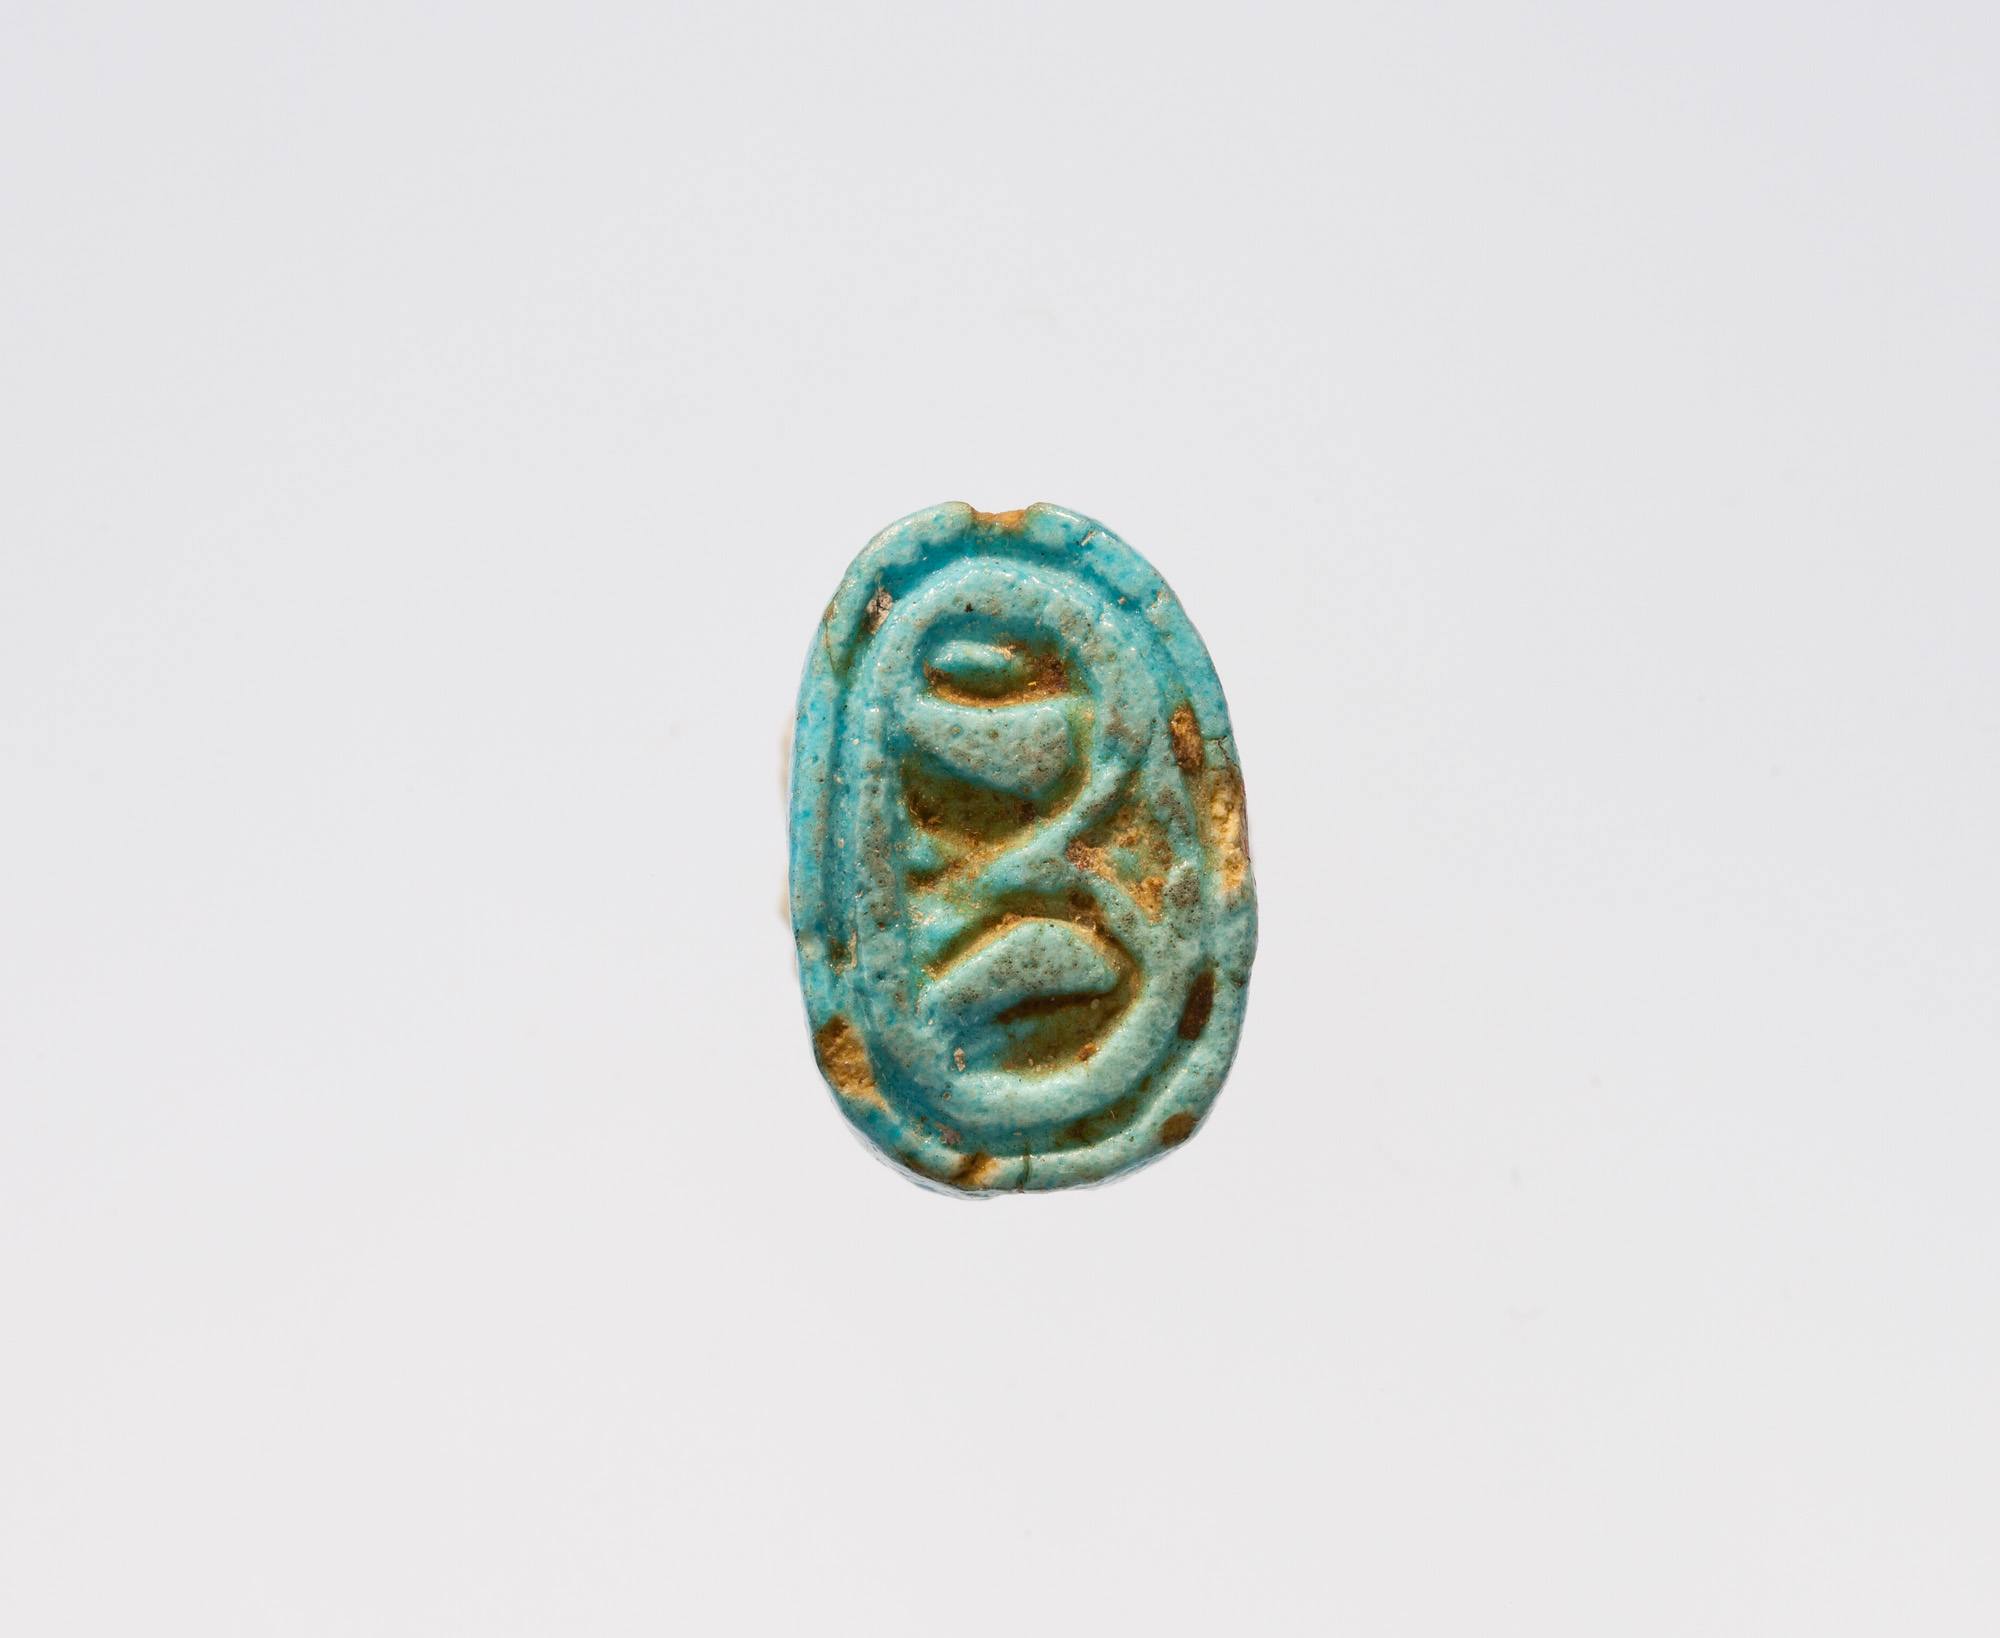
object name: scarab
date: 1479-1458 BCE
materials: faience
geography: egypt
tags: scarabs